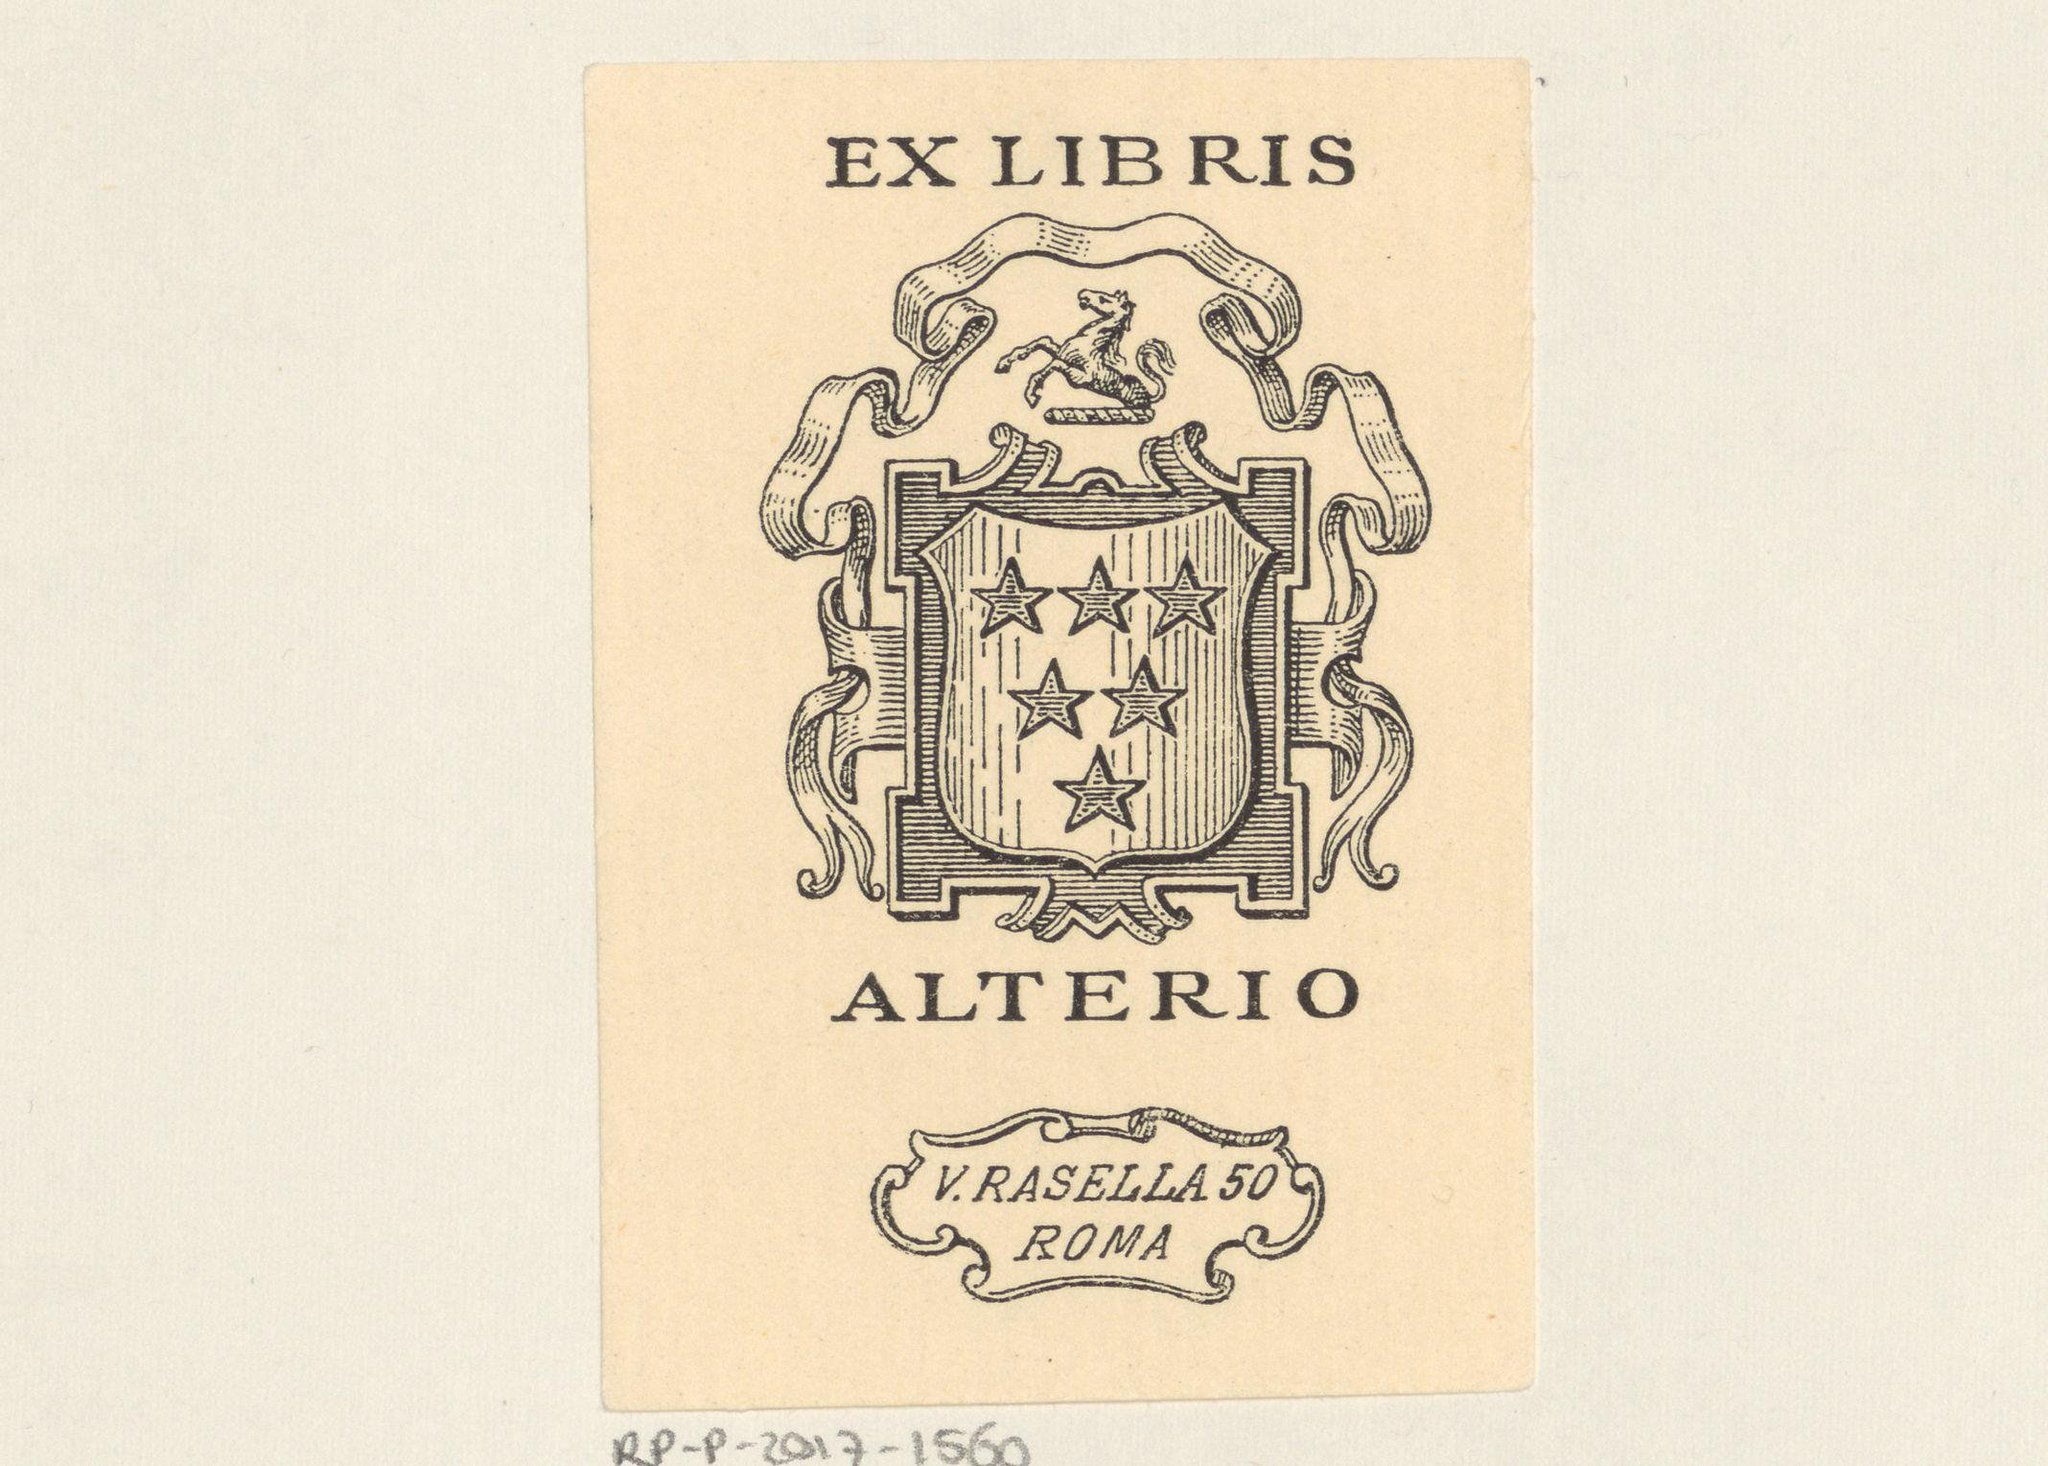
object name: bookplate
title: Ex libris van Alterio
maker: Anonymous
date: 1900-1999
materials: paper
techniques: printing block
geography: italy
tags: stars, horse, armorial bearing, heraldry